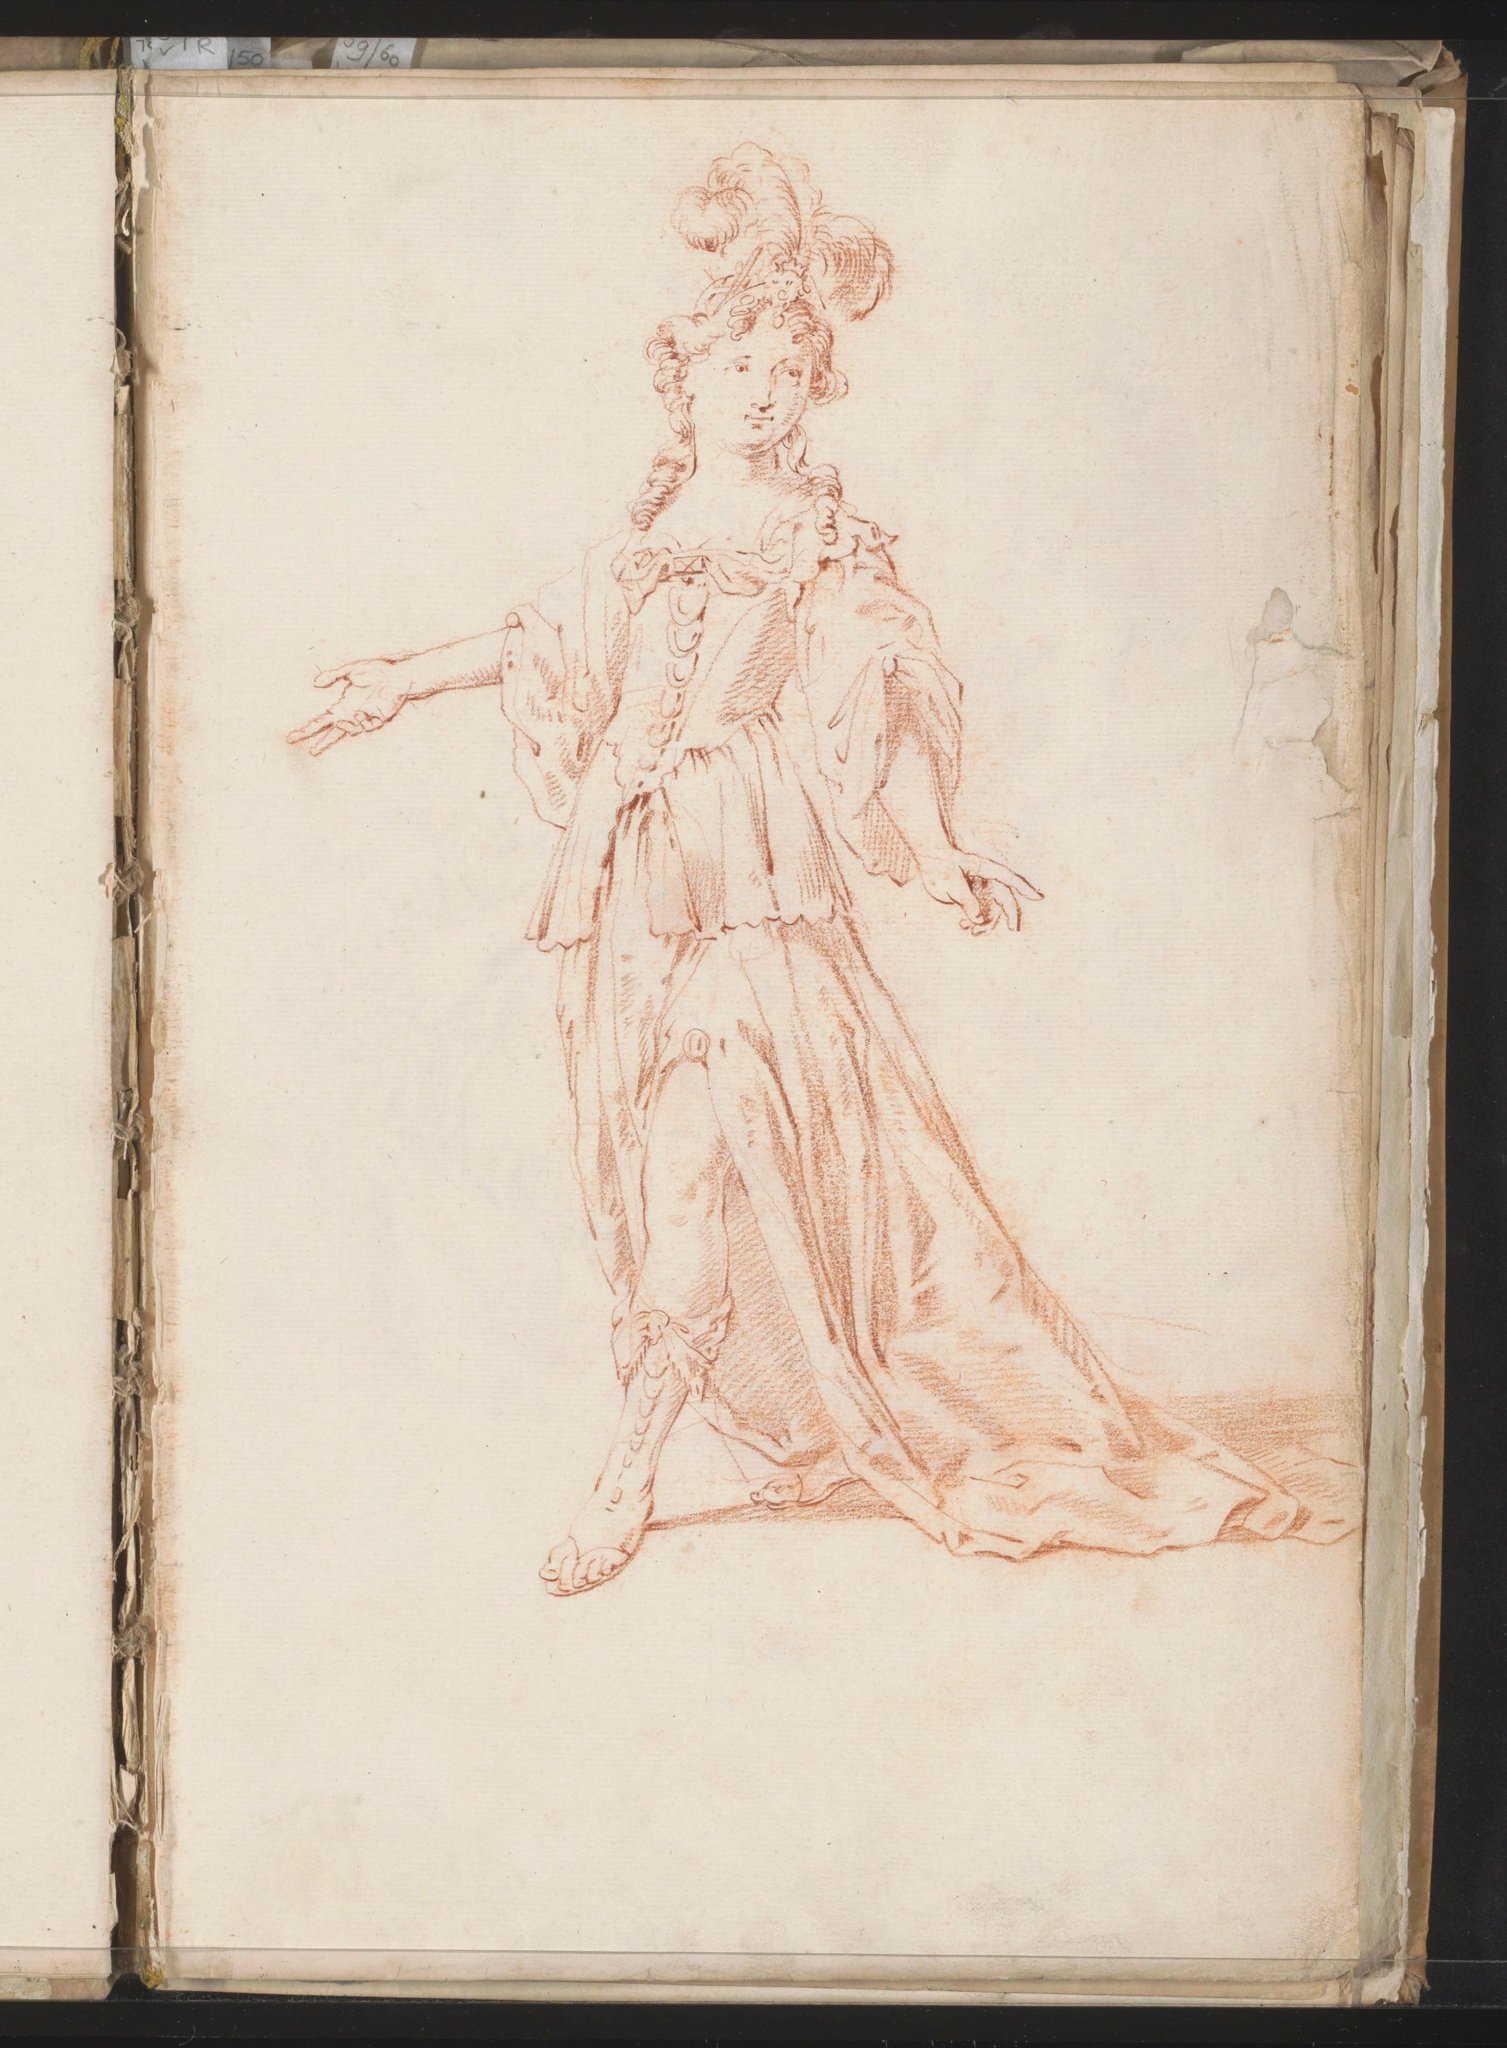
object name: sketchbook leaf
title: Vrouw met struisvogelveren op haar hoed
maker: jacob toorenvliet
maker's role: draughtsman, painter, print maker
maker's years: 1640-1719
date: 1701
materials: chalk, paper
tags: standing figure, accessories (~ clothing)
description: Blad 5 recto uit een schetsboek met 63 bladen.